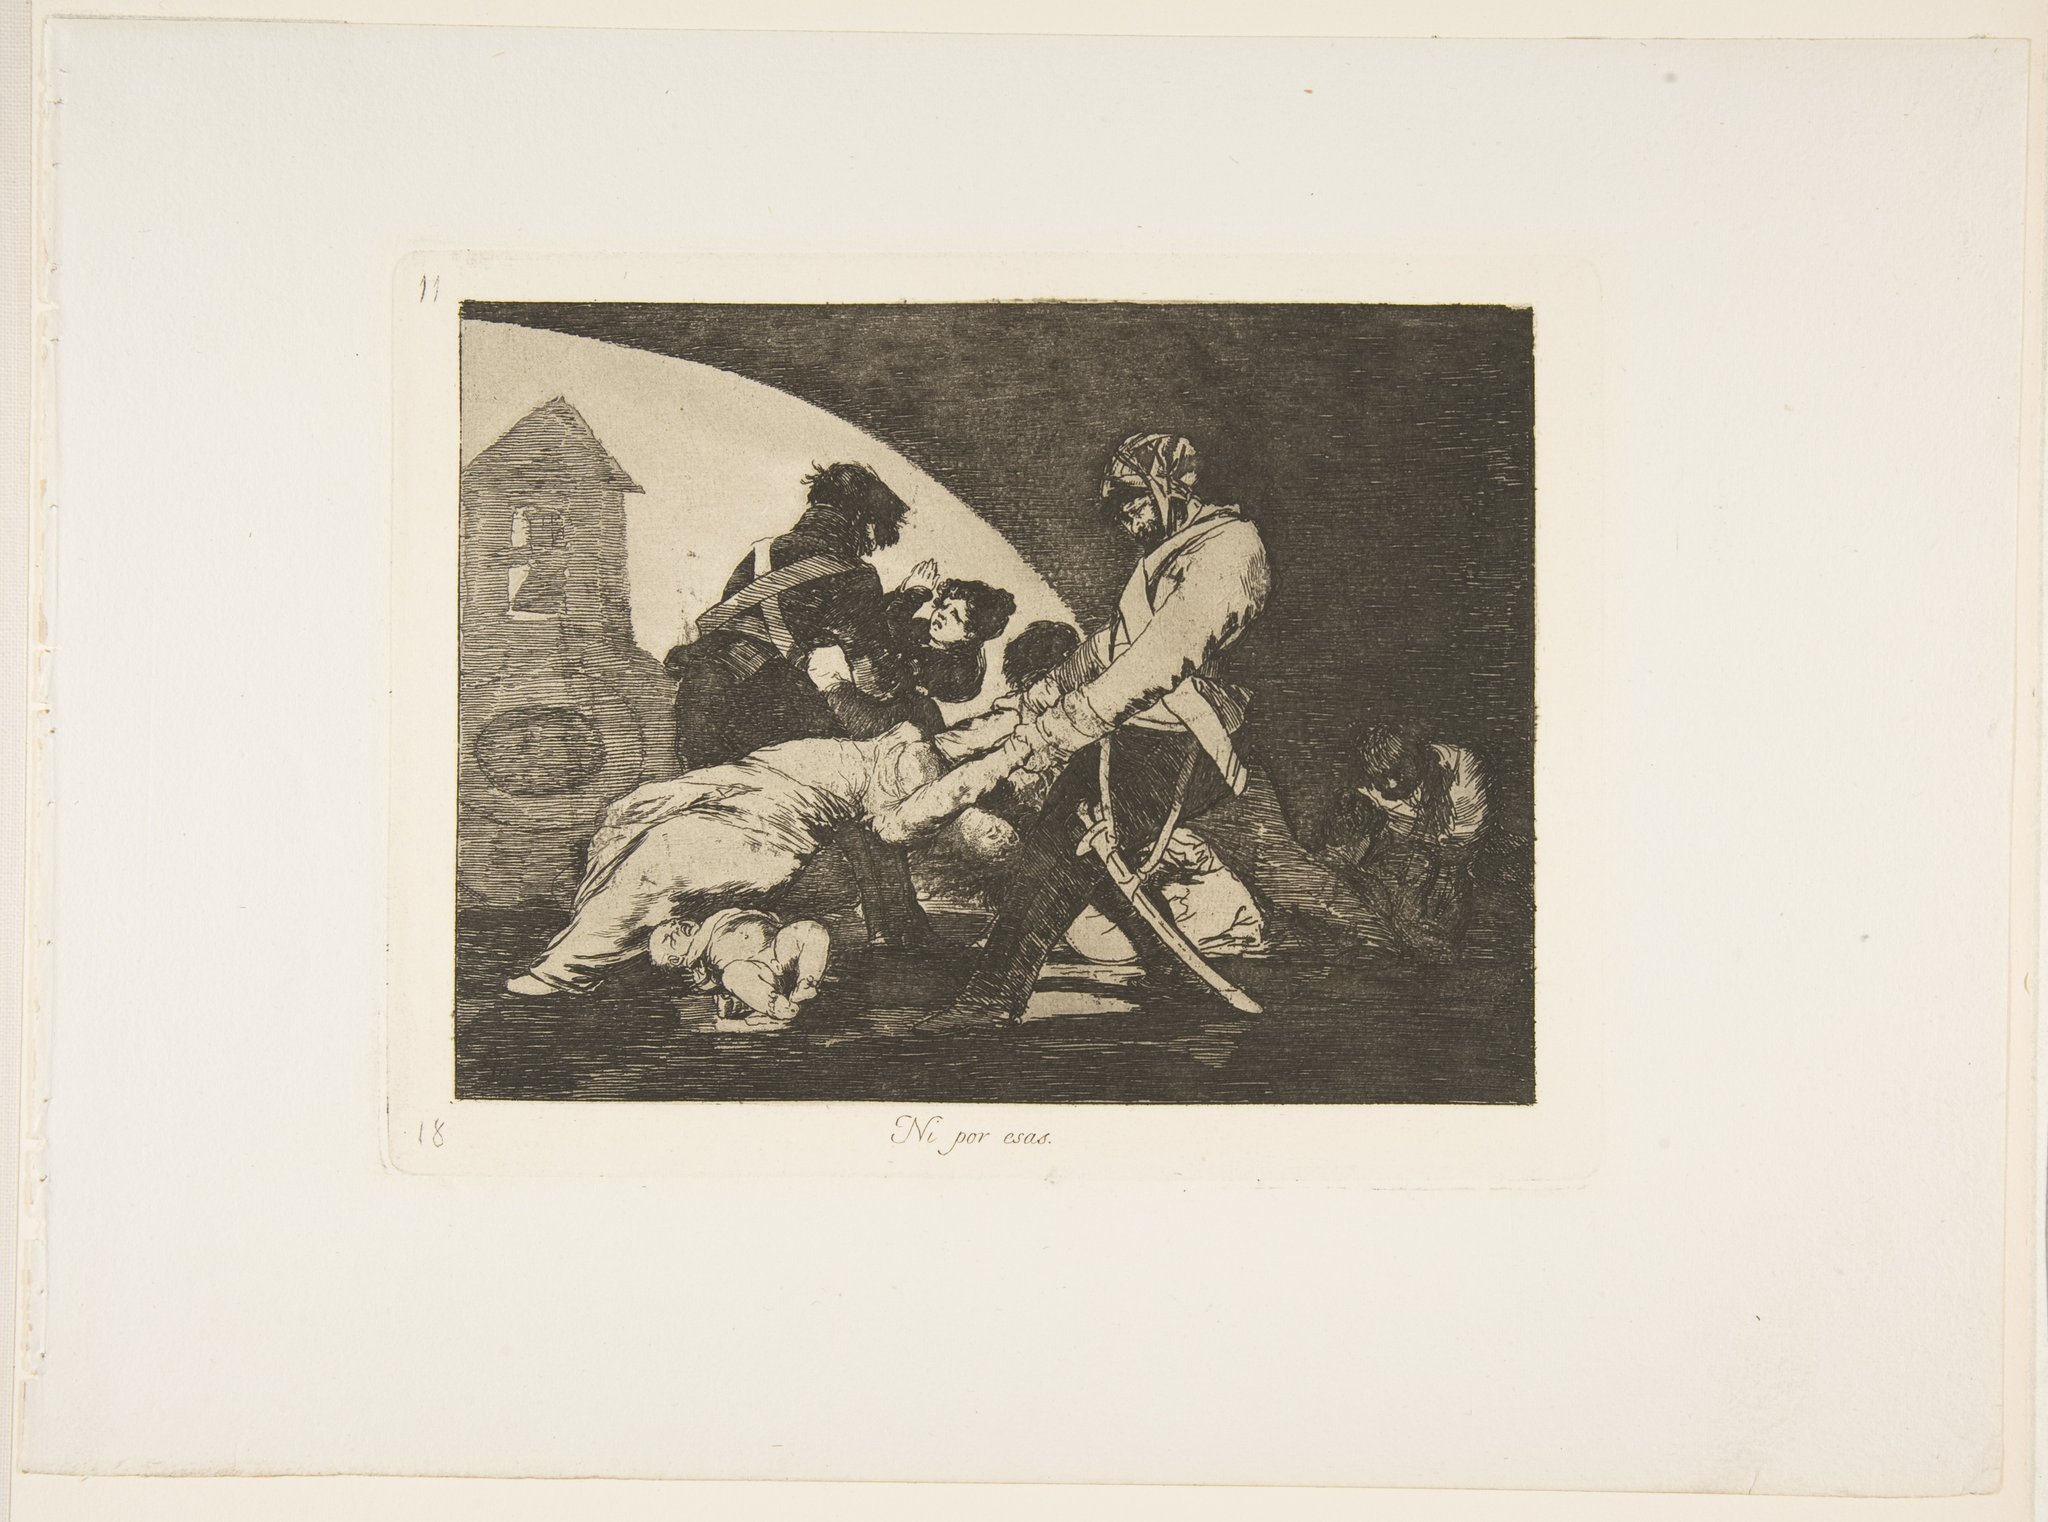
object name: print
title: Plate 11 from "The Disasters of War" (Los Desastres de la Guerra): 'Neither do these' (Ni por esas)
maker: goya (francisco de goya y lucientes)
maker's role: artist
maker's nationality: spanish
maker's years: 1746-1828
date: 1810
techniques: engraving, drypoint, etching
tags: infants,men,women